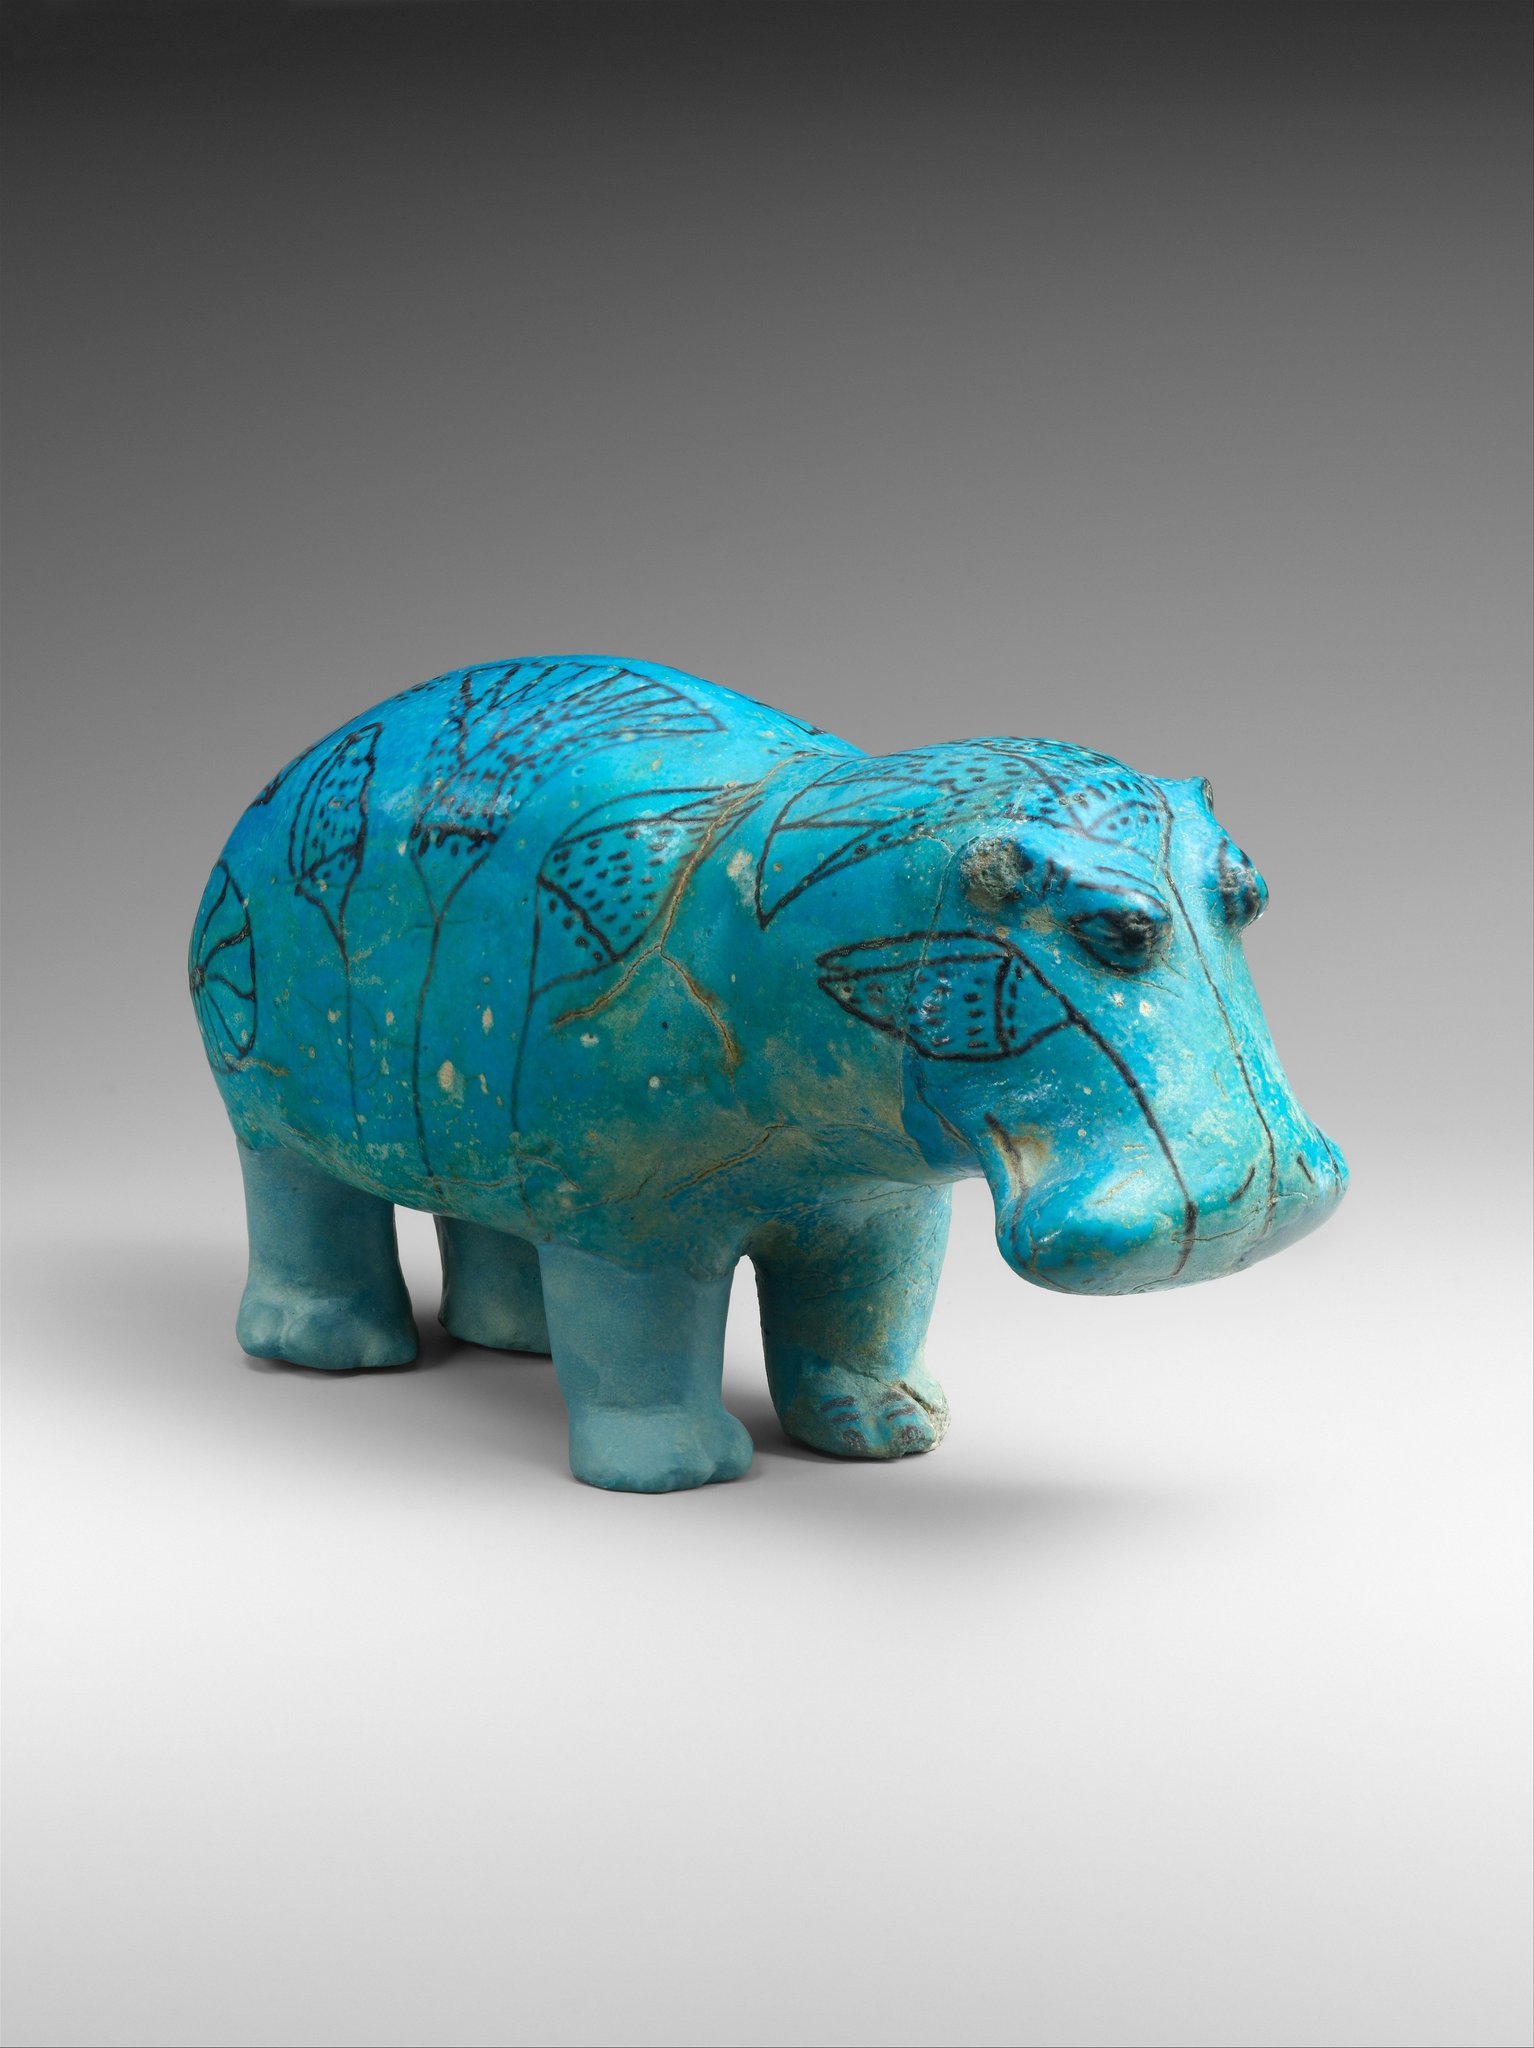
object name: figurine, hippopotamus william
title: Hippopotamus ("William")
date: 1961-1878 BCE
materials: faience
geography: egypt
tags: hippos